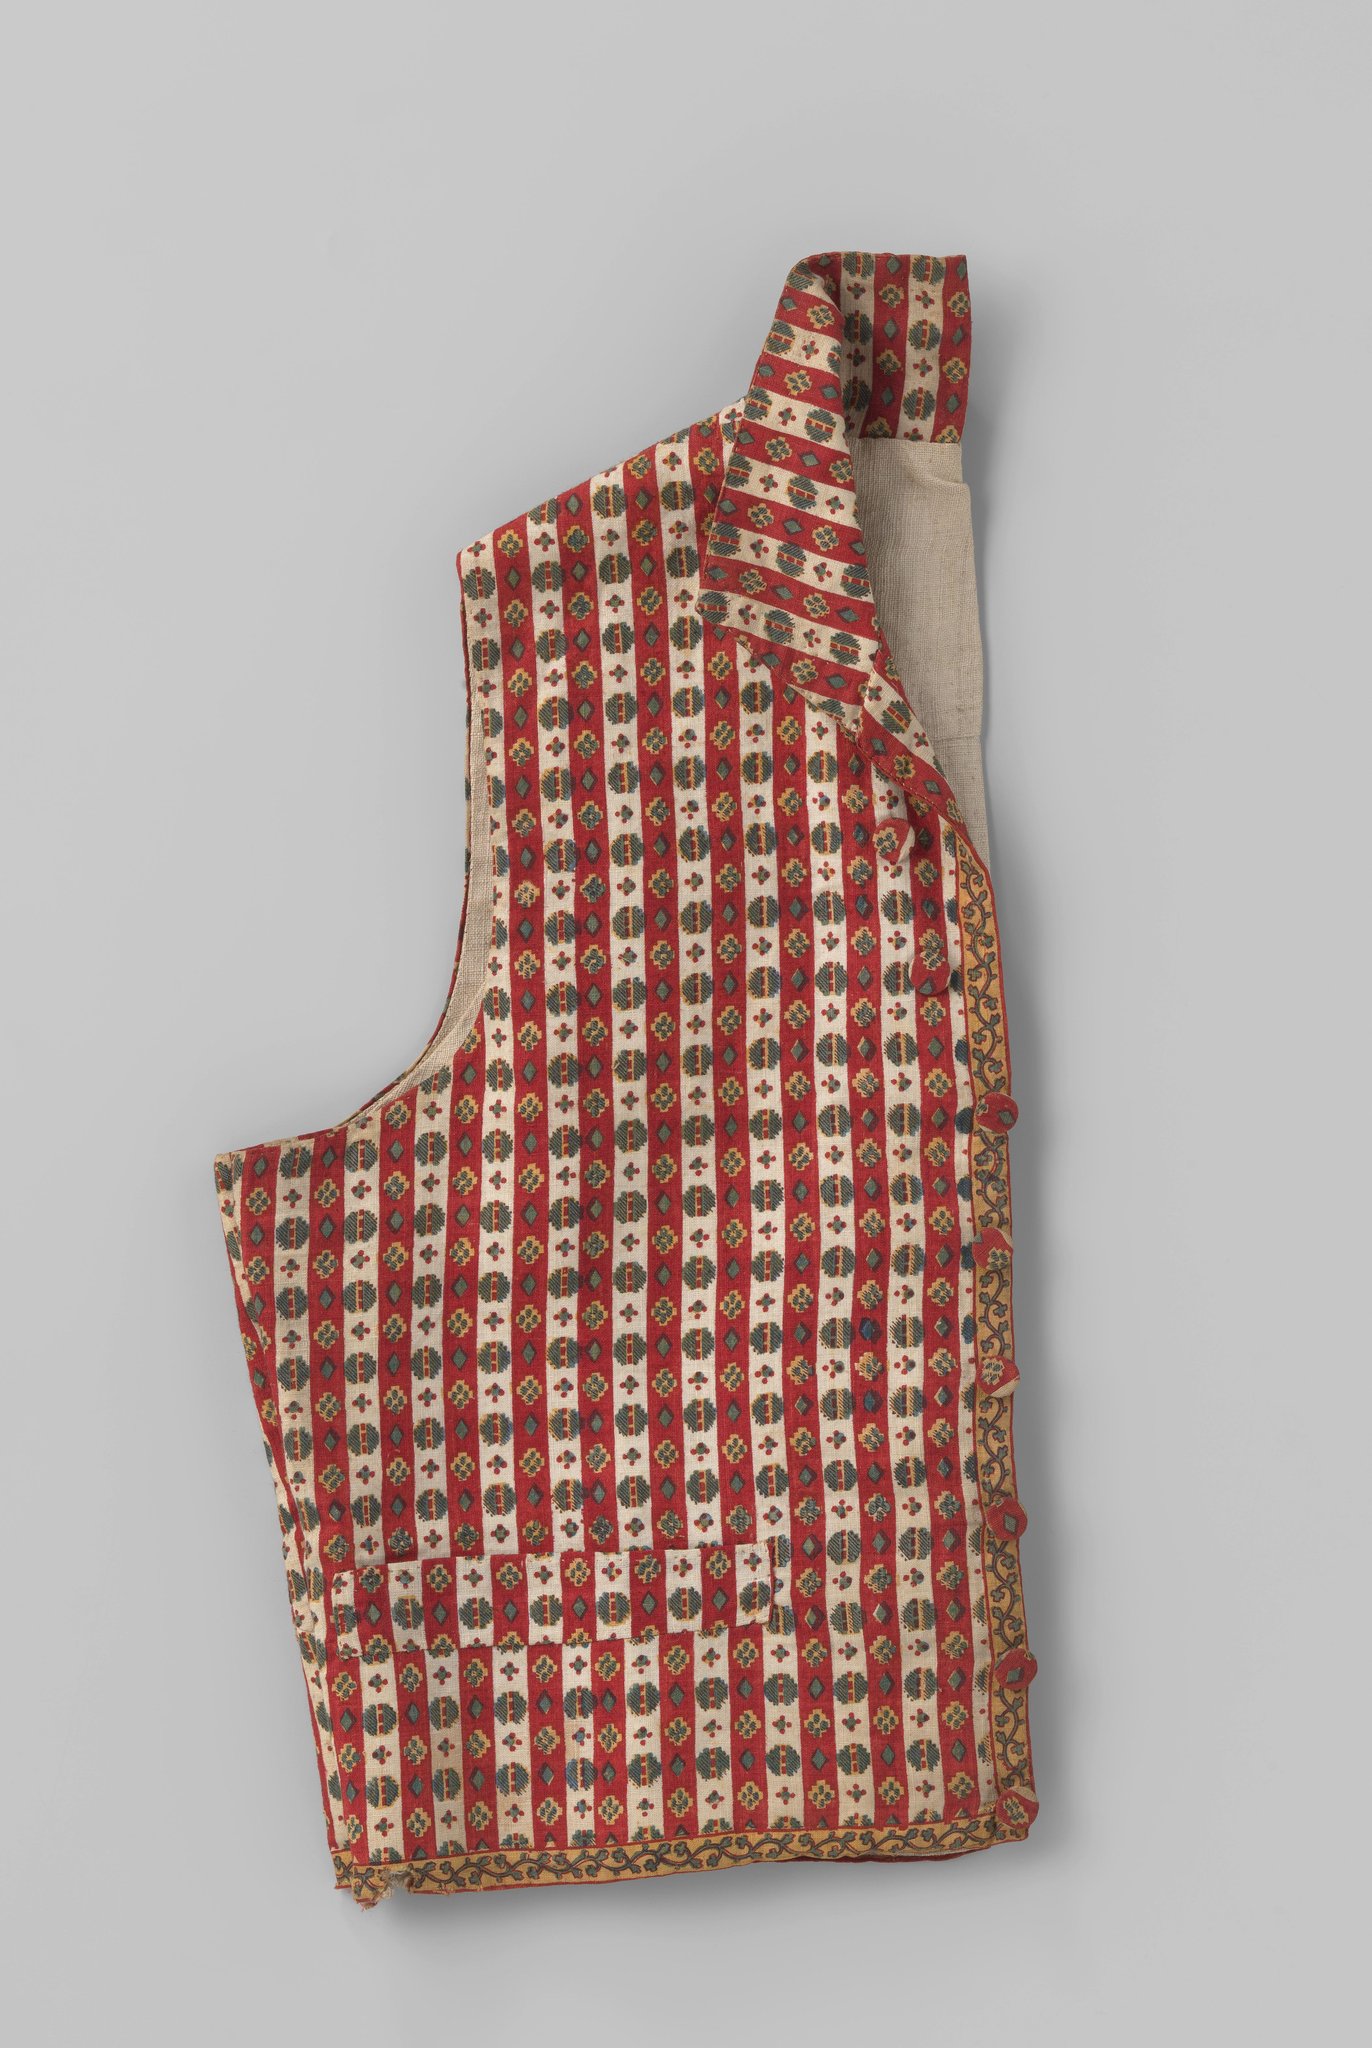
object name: menswear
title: Vest met zes stofknopen, geflankeerd door twee loze knopen, van bedrukt linnen met rode en witte strepen, versierd met diverse motieven in geel, groen, rood en zwart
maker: Anonymous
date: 1810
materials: linen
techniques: printing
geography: friesland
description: Herenvest van bedrukt linnen met rode en witte strepen, vol groene/gele noppen. Vest met korte recht afgesneden voorpanden. Hoge hals, met staand boord. Rug en voerring van grof linnen. Zes met stof beklede platte knoopjes en knoopsgaten, waarboven links en rechts twee loze knoopjes. De stof heeft naast het middenpatroon staande en liggende randjes van geel met groene rank. Briefje: 1975 Tjalma.